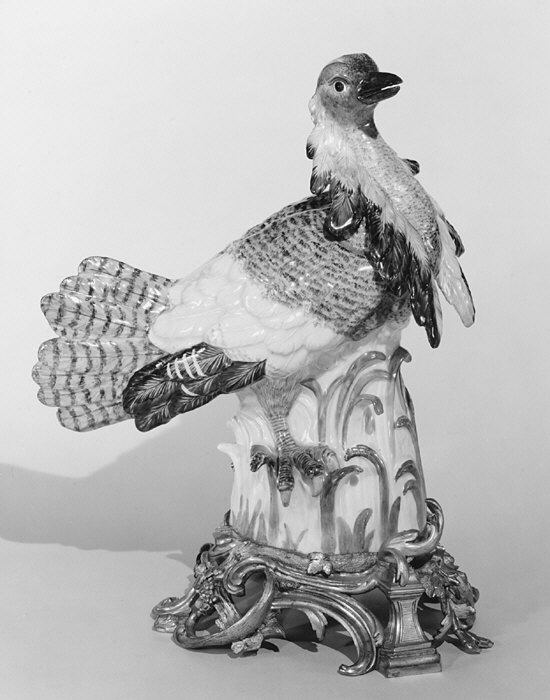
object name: figure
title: Ruffed bustard (one of a pair)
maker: meissen manufactory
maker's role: manufactory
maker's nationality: german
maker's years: 1710-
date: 1732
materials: hard paste porcelain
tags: birds